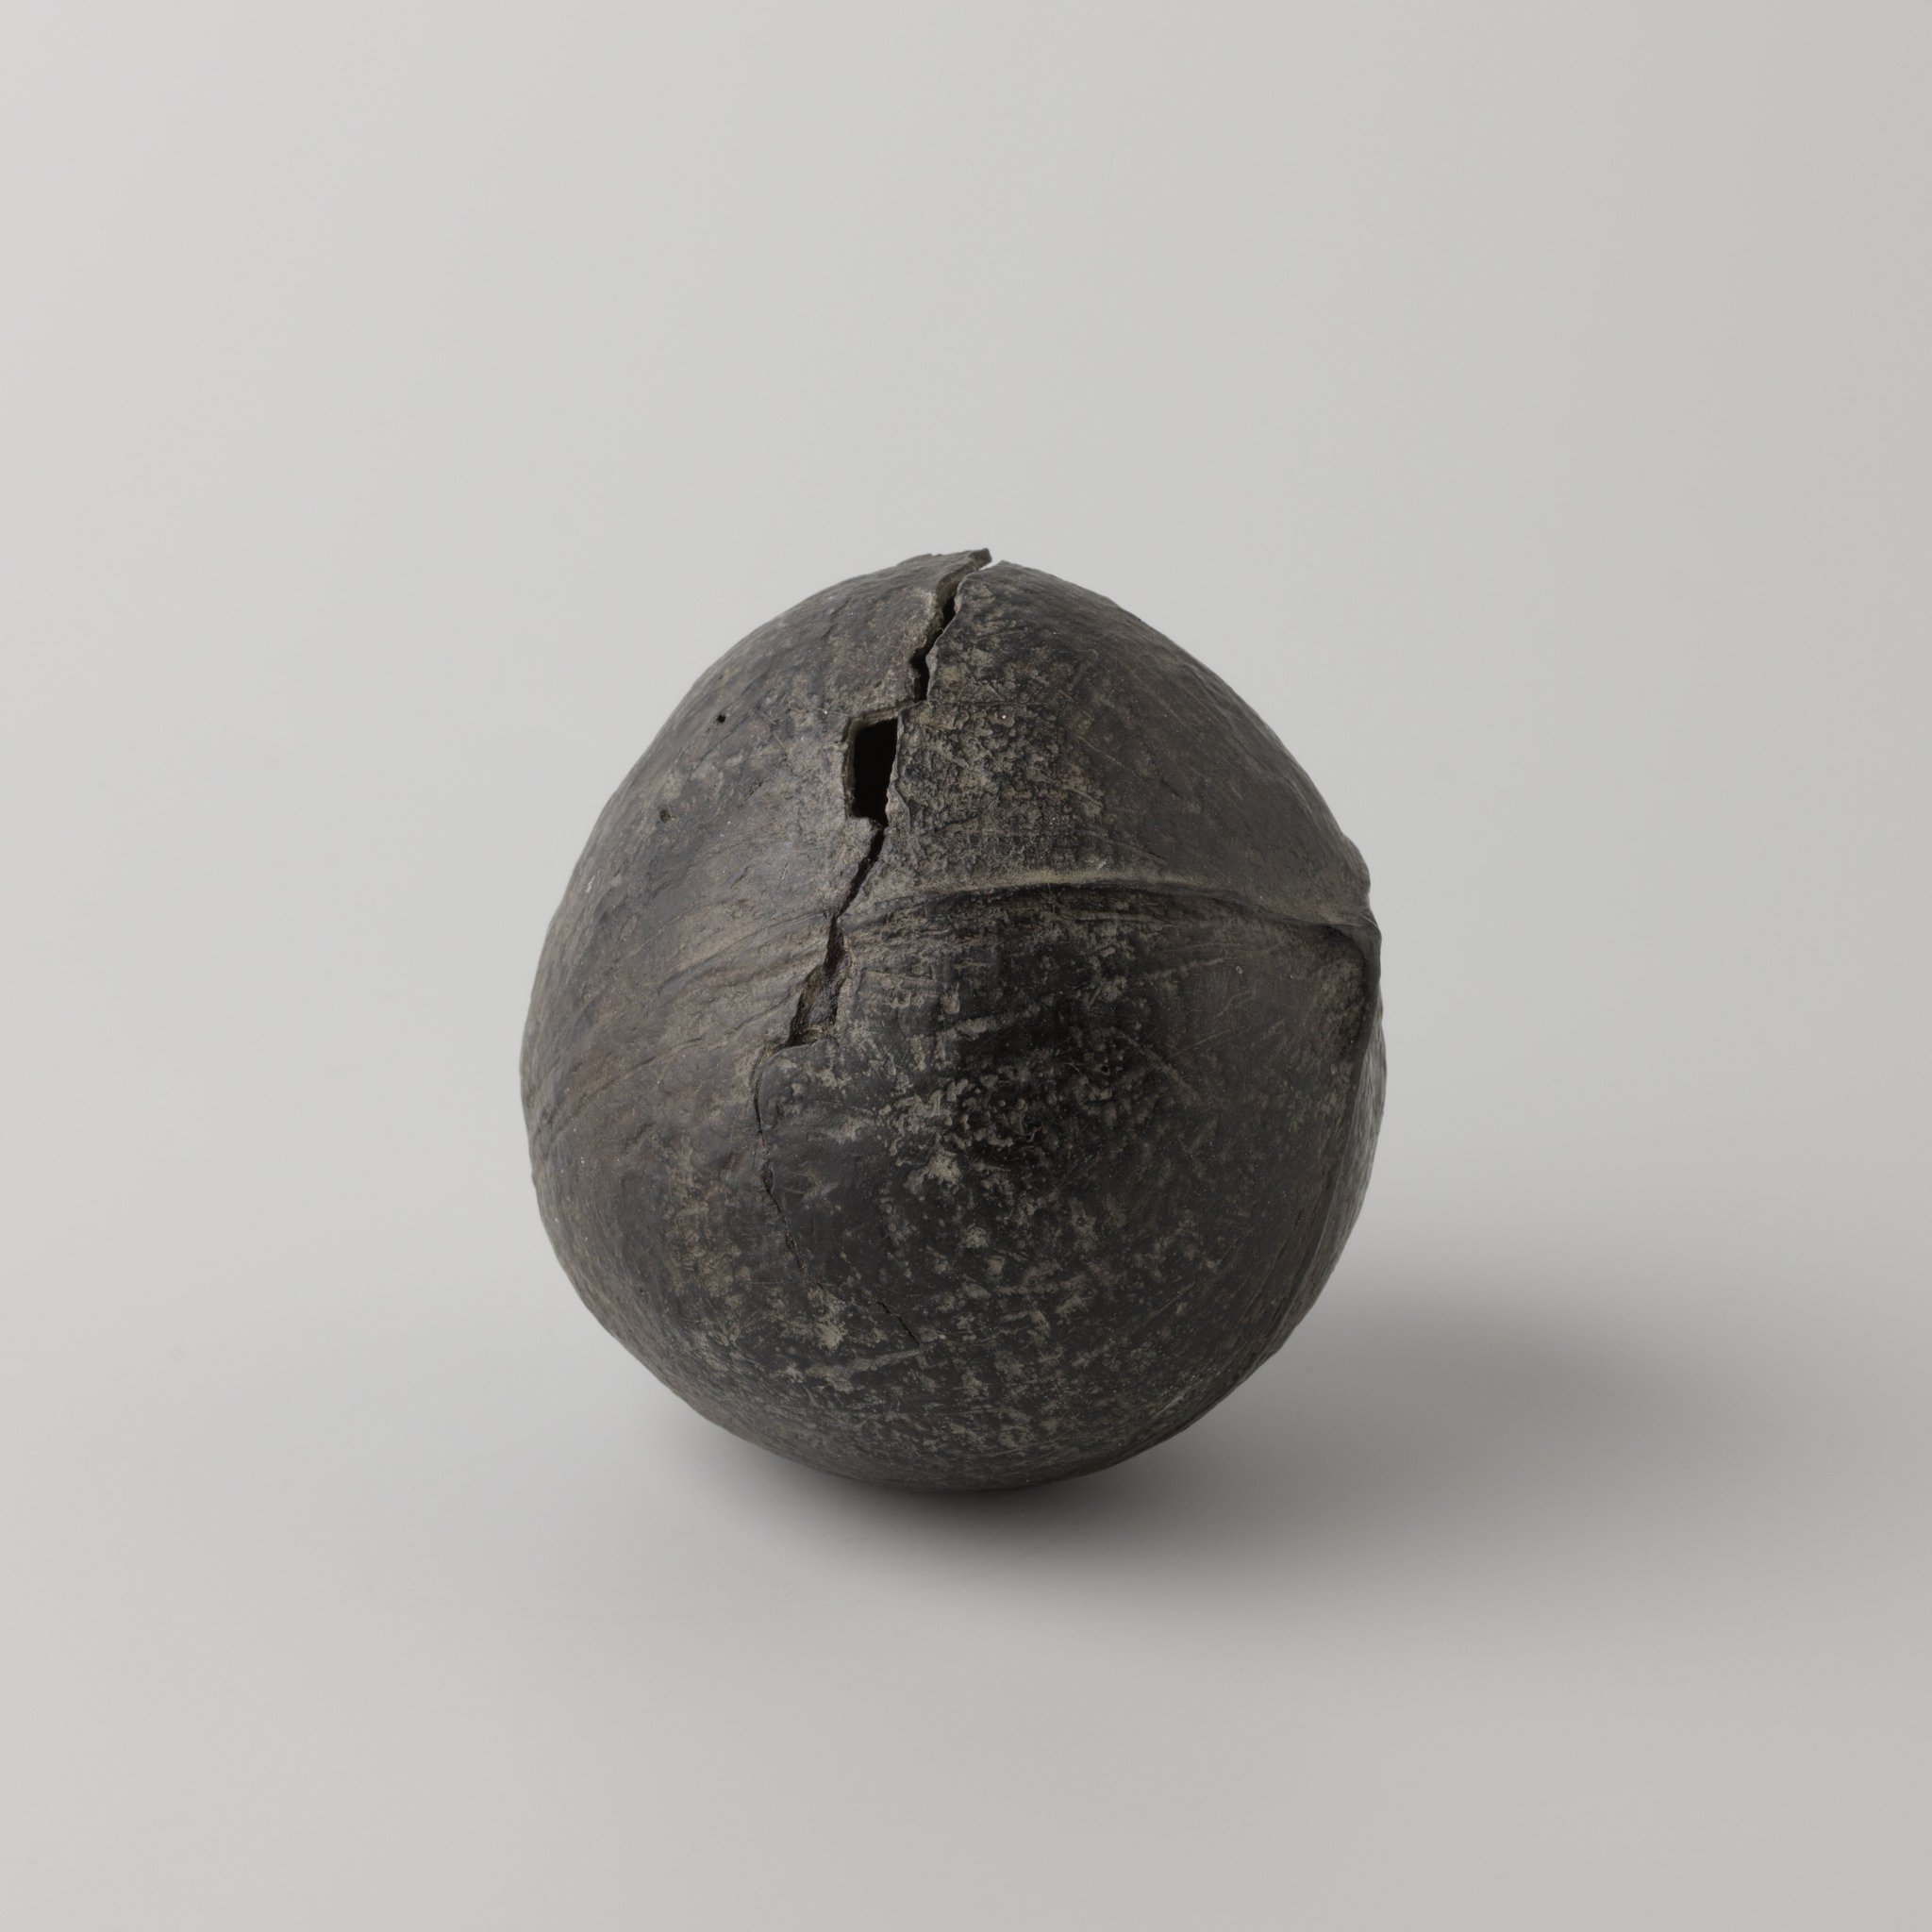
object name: coconut fruit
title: Kokosnoot uit V.O.C.-schip de 'Witte Leeuw'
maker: Anonymous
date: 1613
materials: plant material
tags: verenigde oostindische compagnie, sint-helena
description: Kokosnoot uit V.O.C.-schip de 'Witte Leeuw'. Gebarsten. Gaatje in de onderkant.